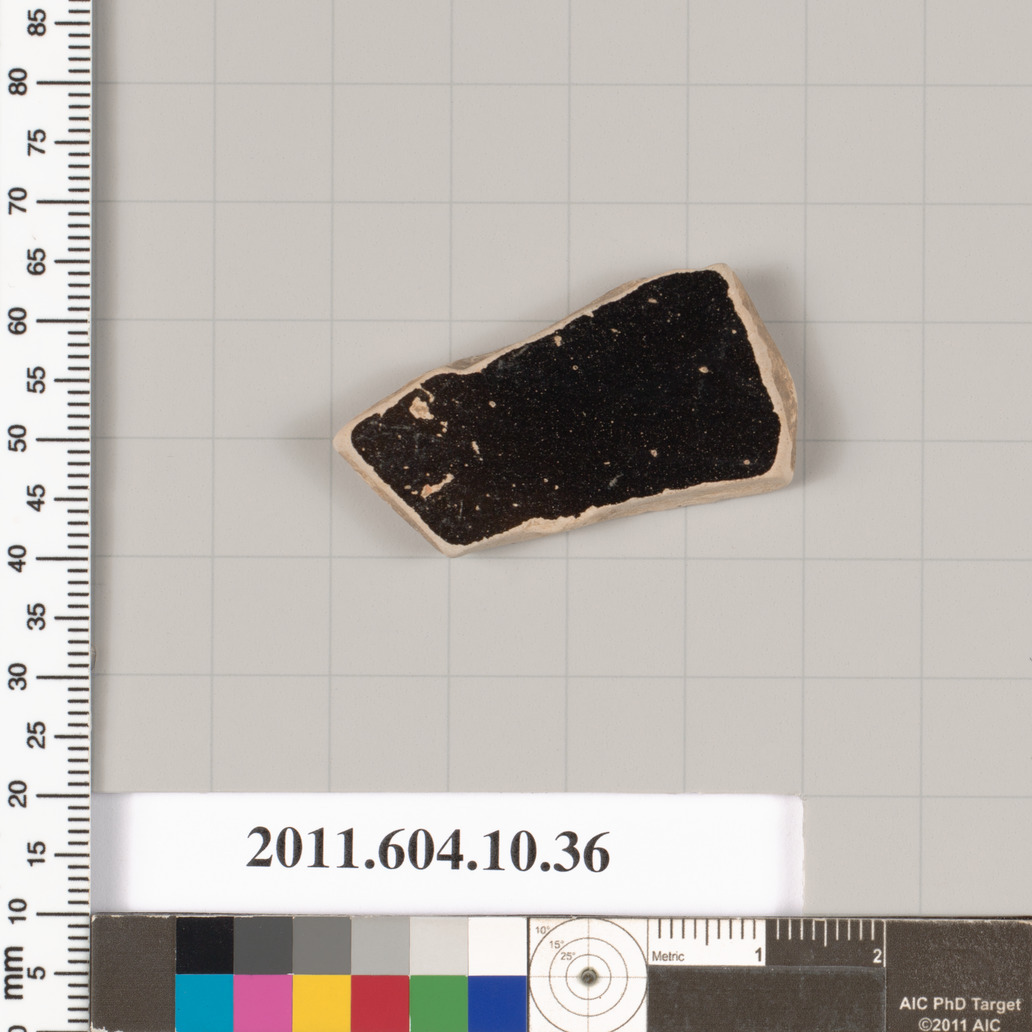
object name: kylix fragment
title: Terracotta fragment of a kylix (drinking cup)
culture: etruscan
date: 434-368 BCE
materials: terracotta